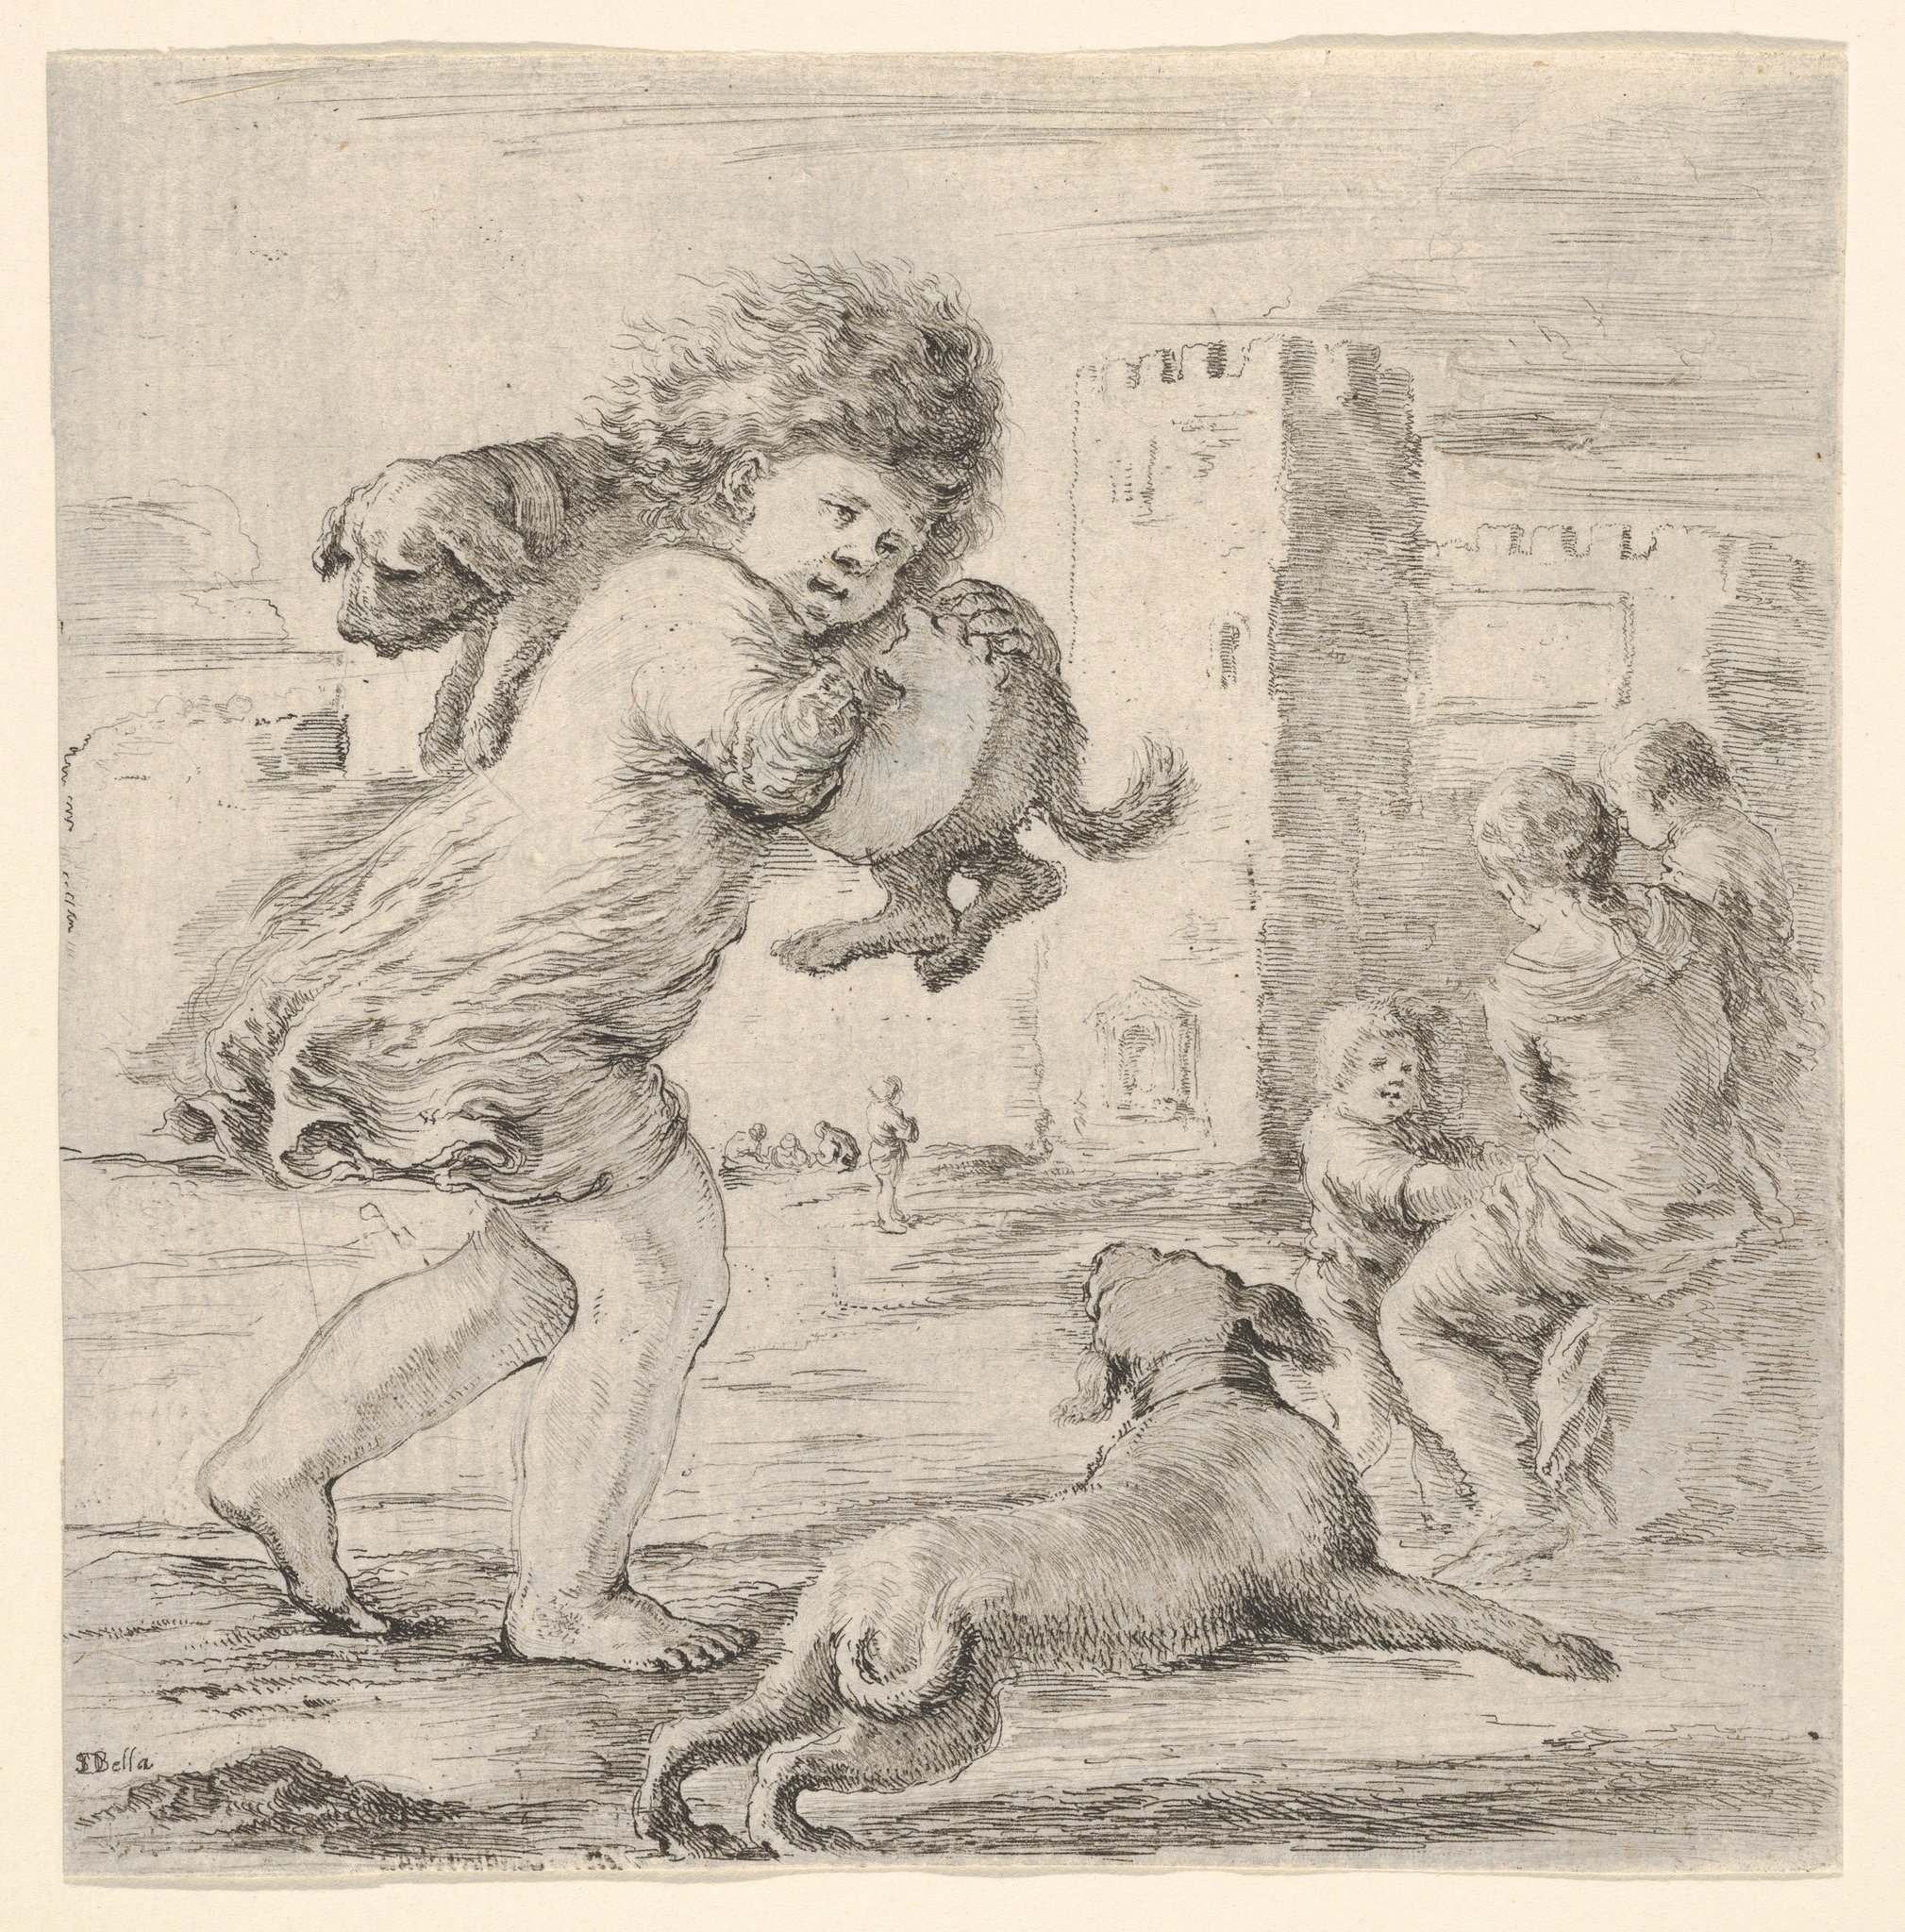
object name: print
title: Child carrying a dog over his shoulder, walking towards the right, another dog running alongside to right, a woman with two children to right in the background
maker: stefano della bella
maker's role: artist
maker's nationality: italian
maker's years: 1610-1664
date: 1660-1664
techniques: etching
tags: boys,women,walking,dogs